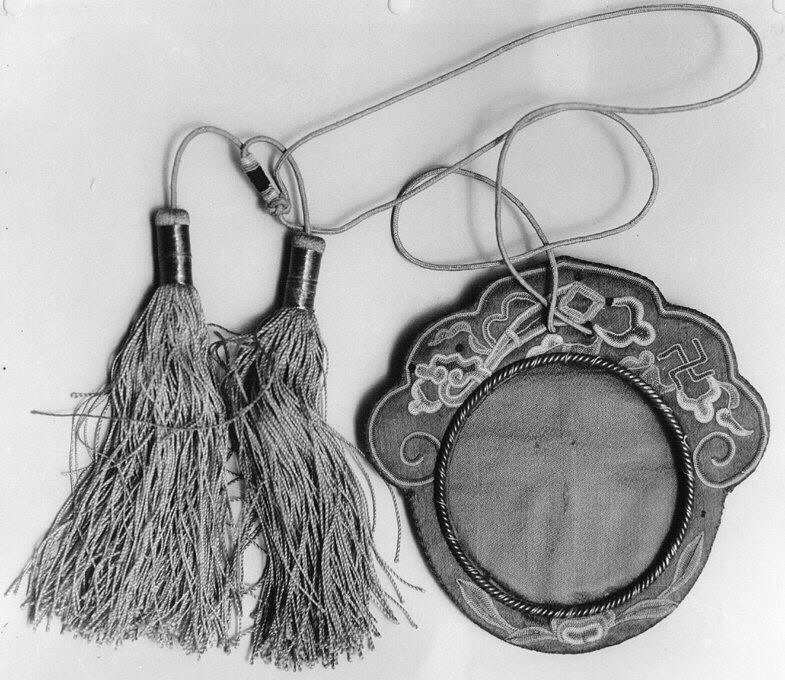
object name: mirror case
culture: chinese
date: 1701-1900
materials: silk